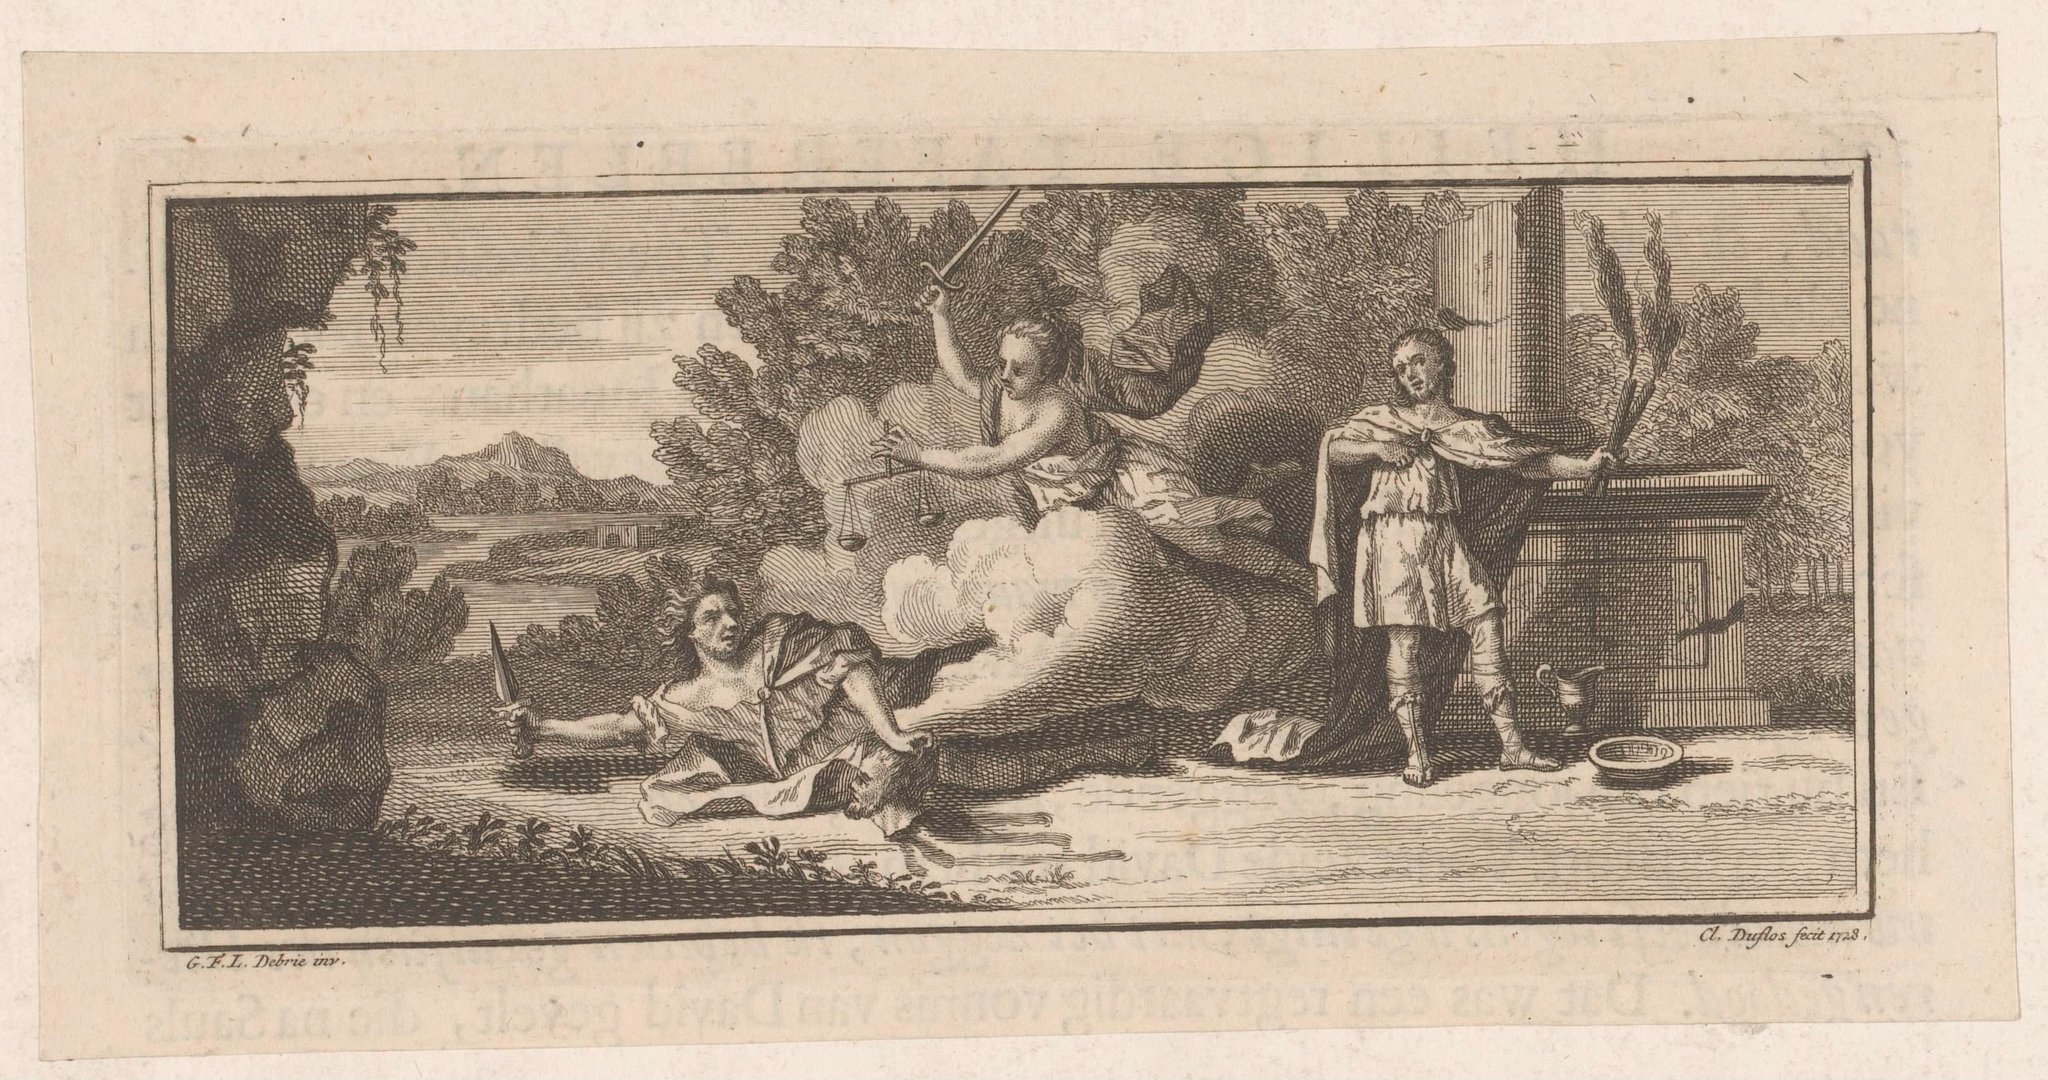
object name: book illustration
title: Allegorische scène met Justitia, moordenaar en man met twee brandende toortsen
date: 1728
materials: paper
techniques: engraving, etching, letterpress printing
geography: france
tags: torch, justitia (justice) as roman personification, head of a beheaded person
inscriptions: collector's mark: Lugt 2228